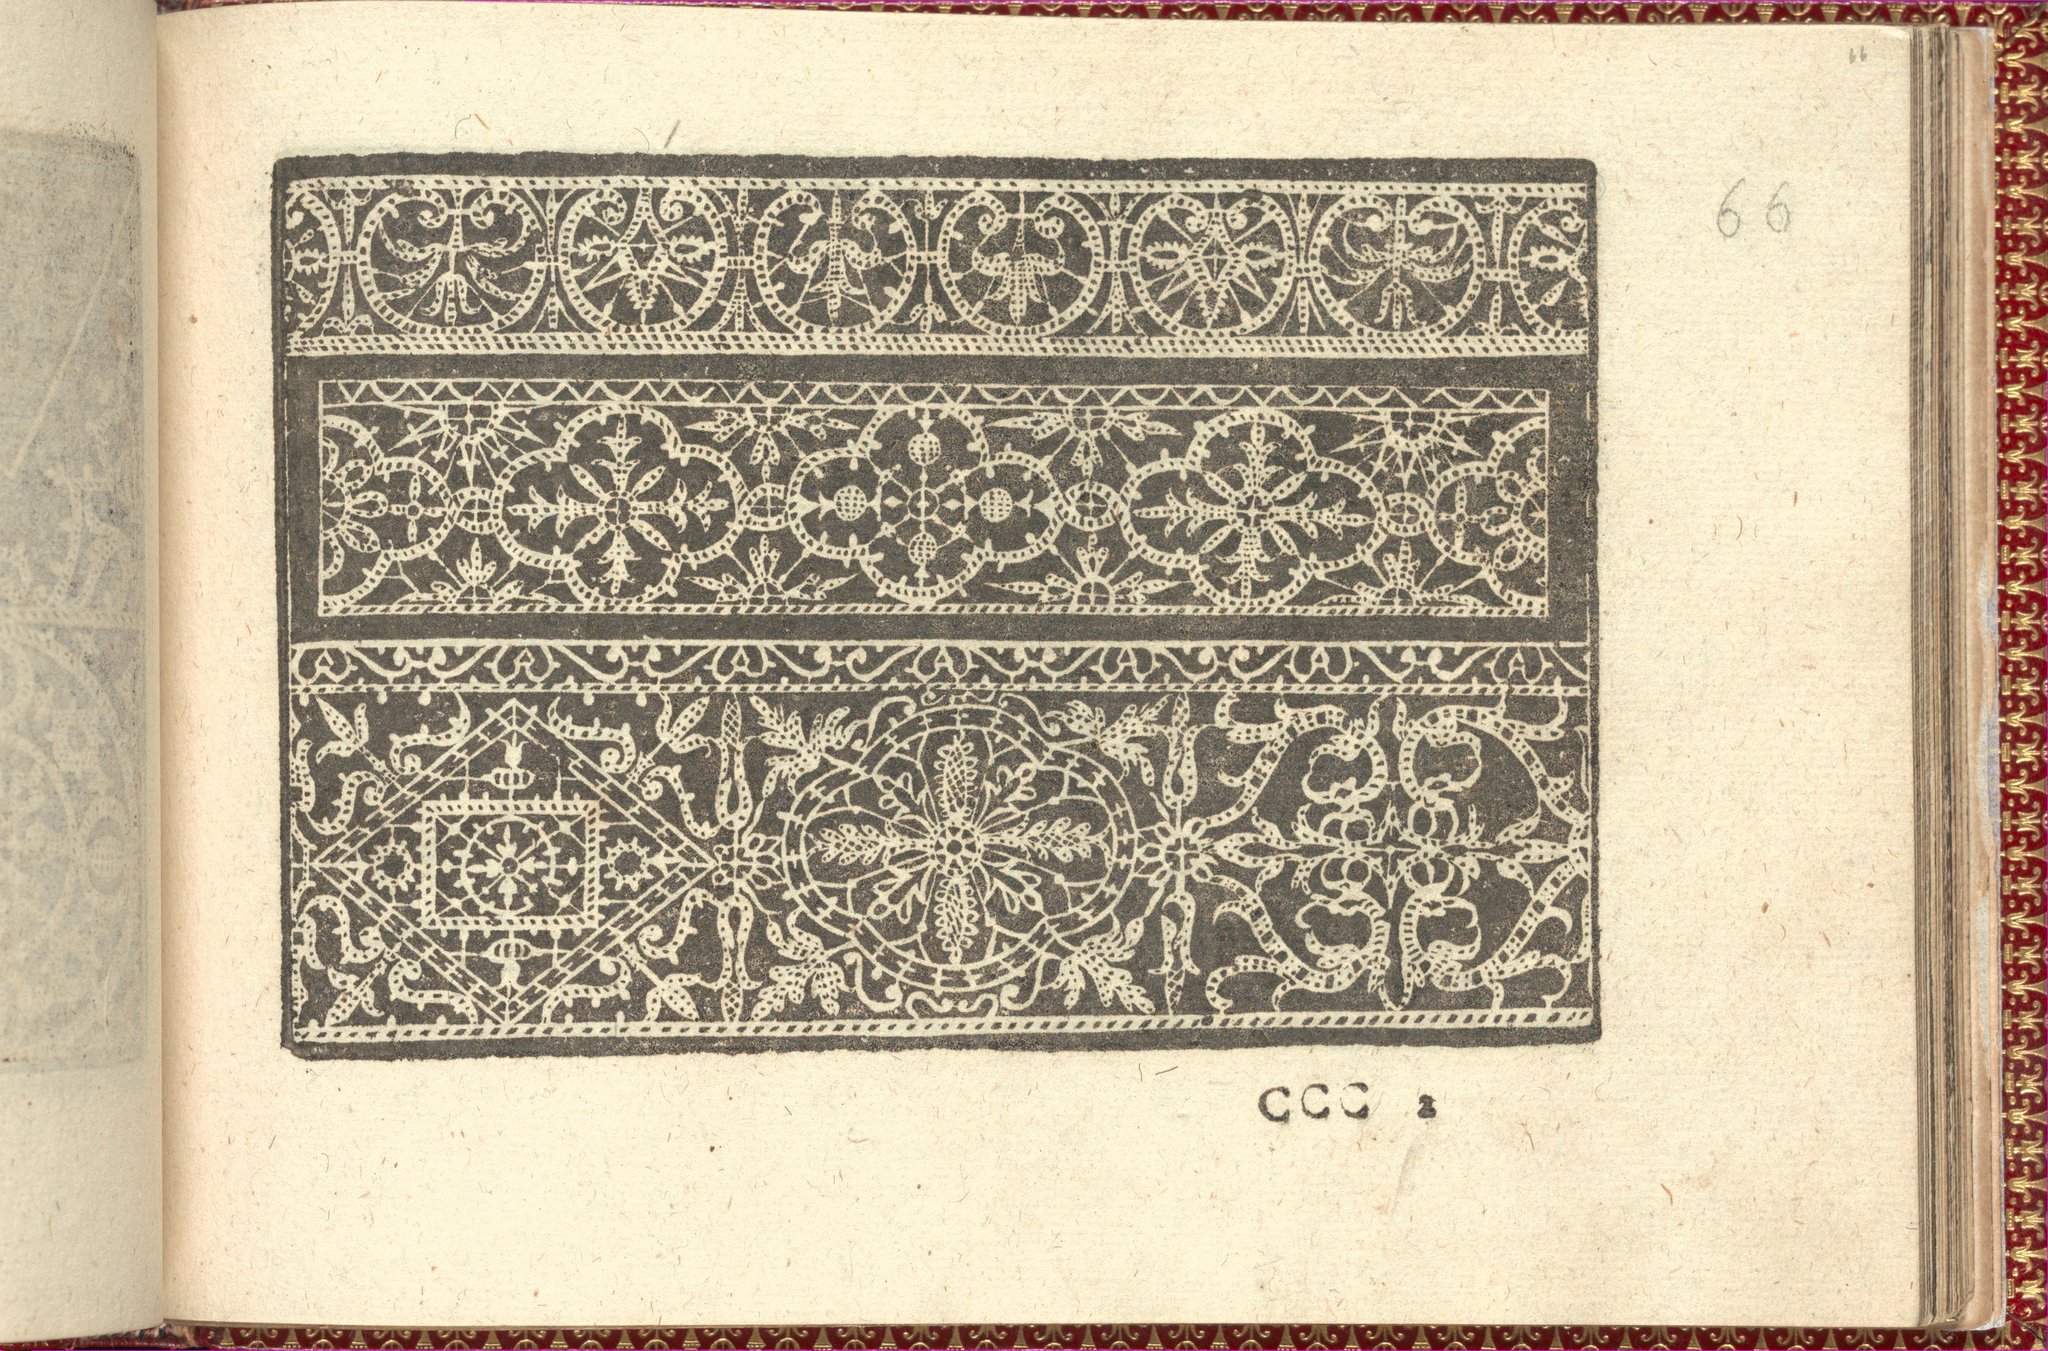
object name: book print ornament architecture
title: Corona delle Nobili et Virtuose Donne: Libro I-IV, page 66 (recto)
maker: cesare vecellio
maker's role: publisher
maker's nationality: italian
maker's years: 1521-1601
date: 1601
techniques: woodcut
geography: italy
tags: ornament